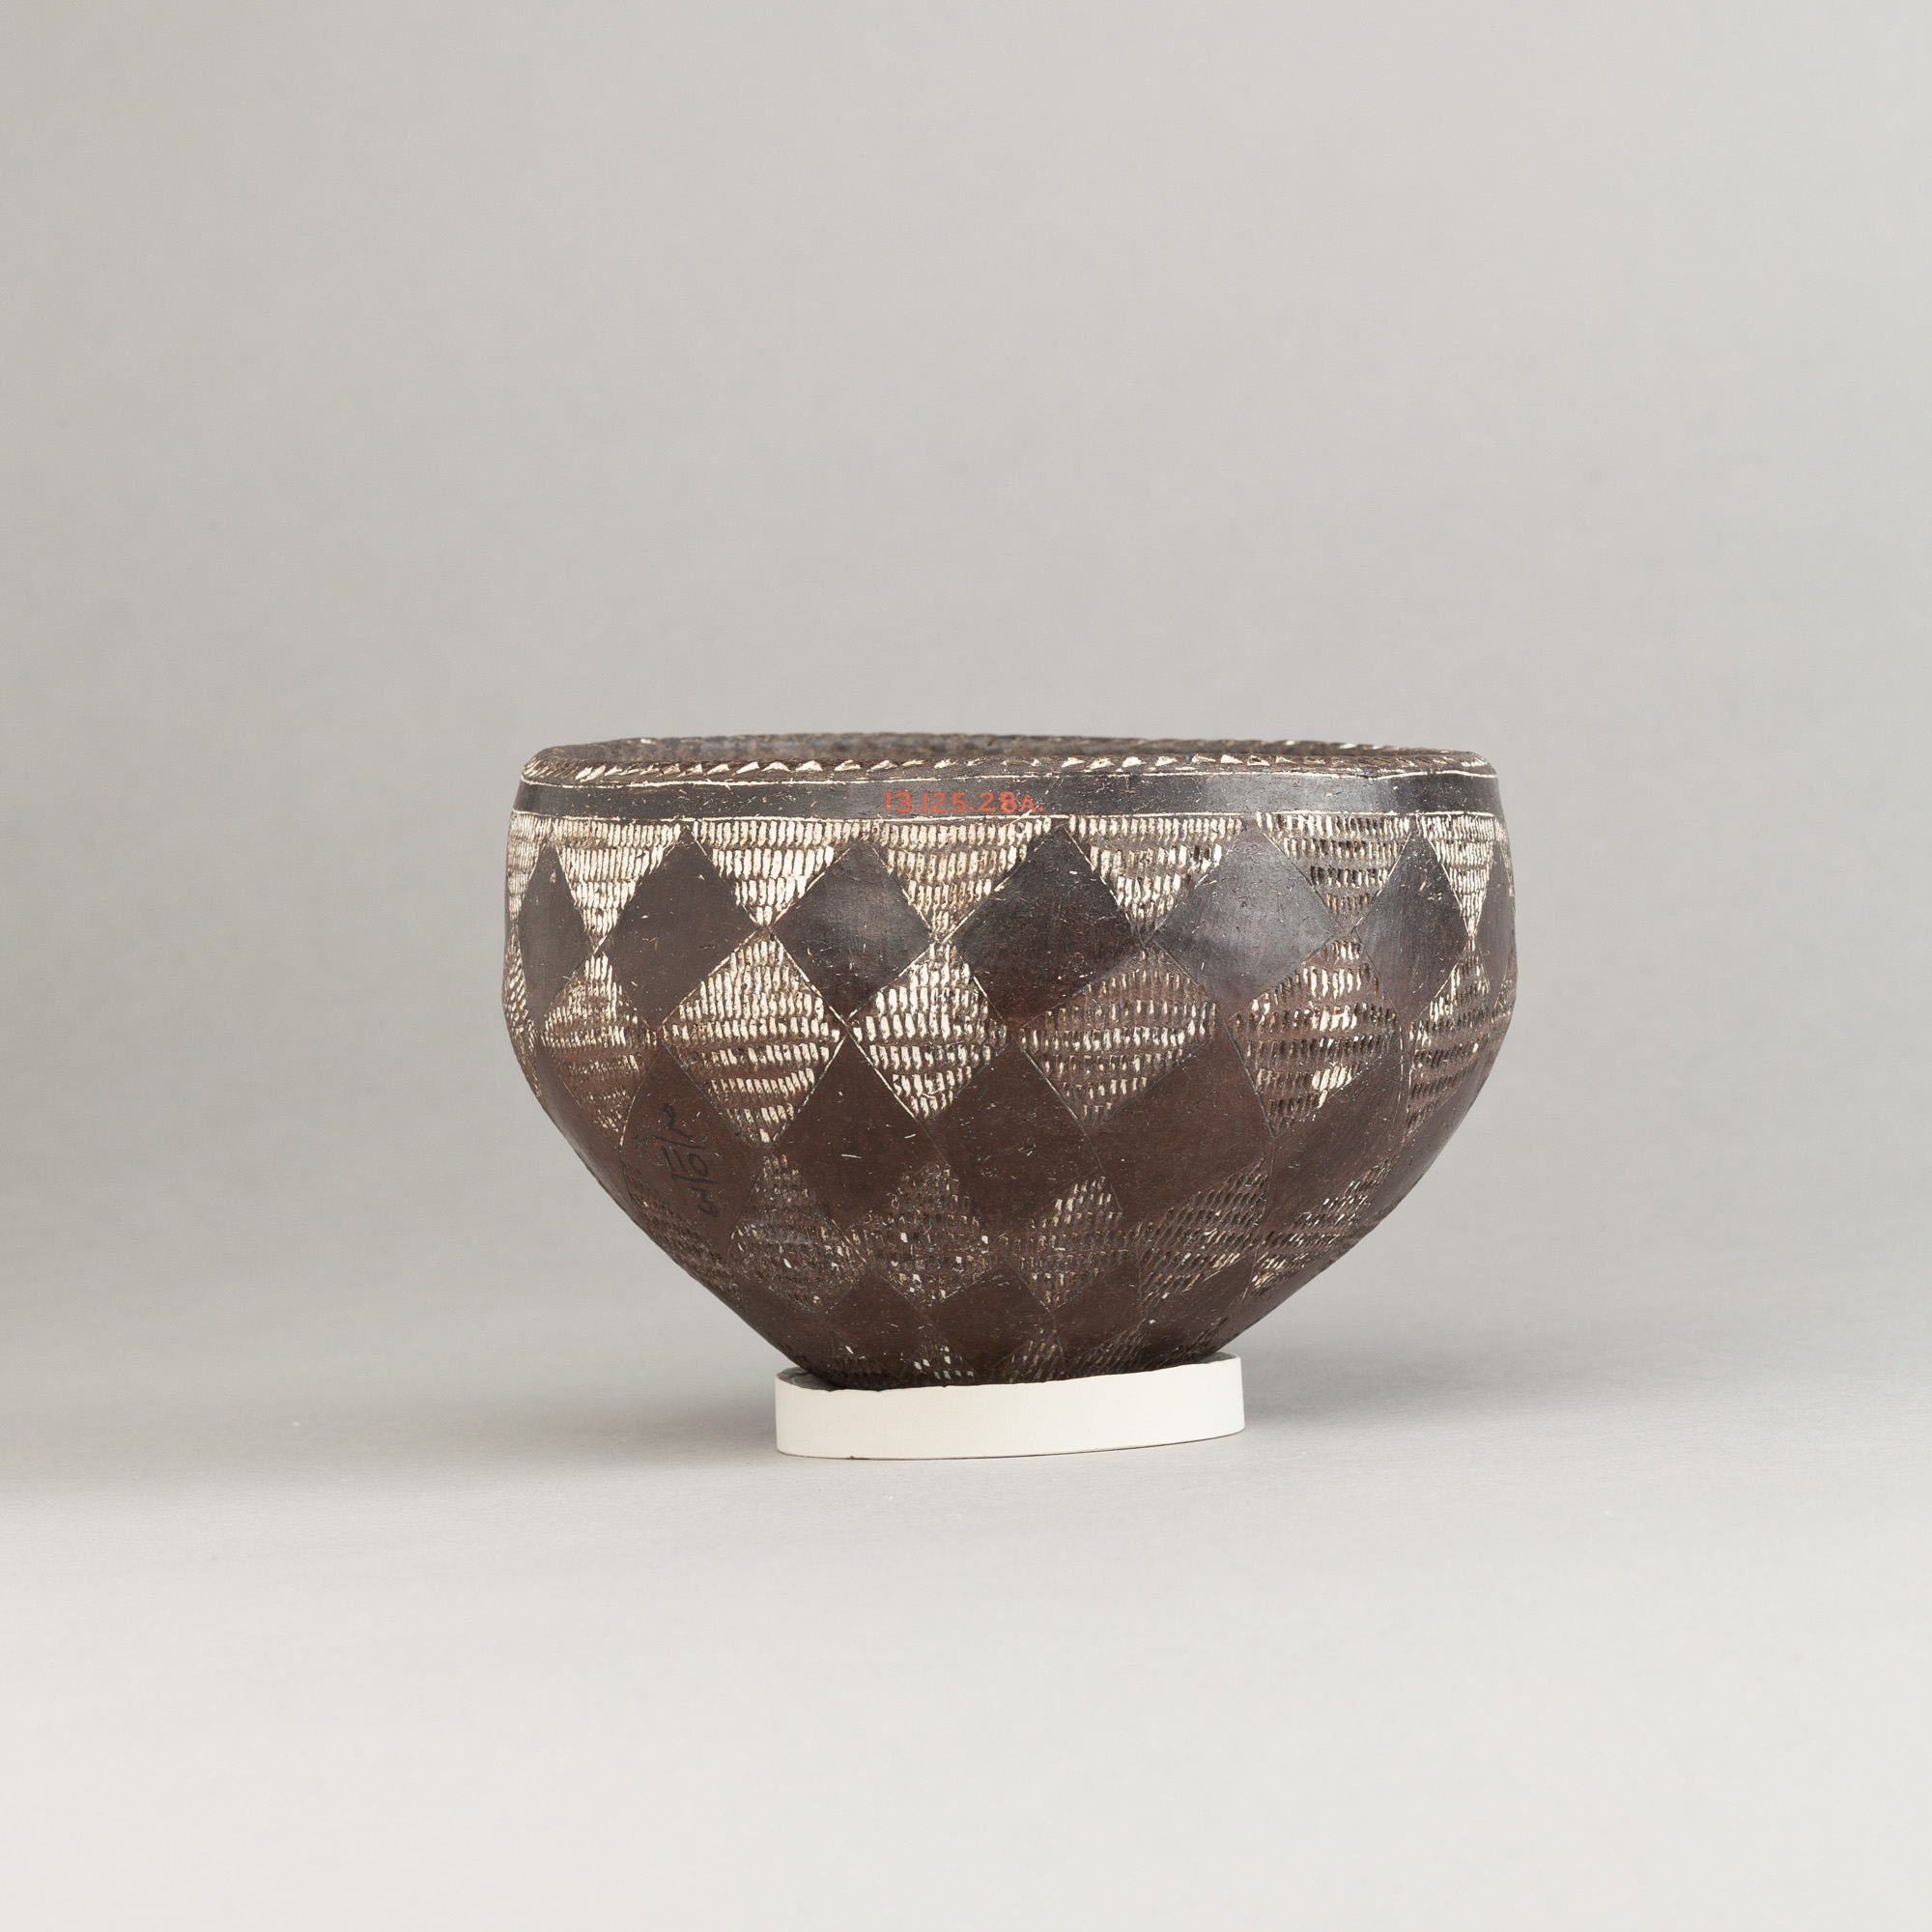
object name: cup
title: Drinking Cup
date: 1900-1550 BCE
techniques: incising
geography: nubia